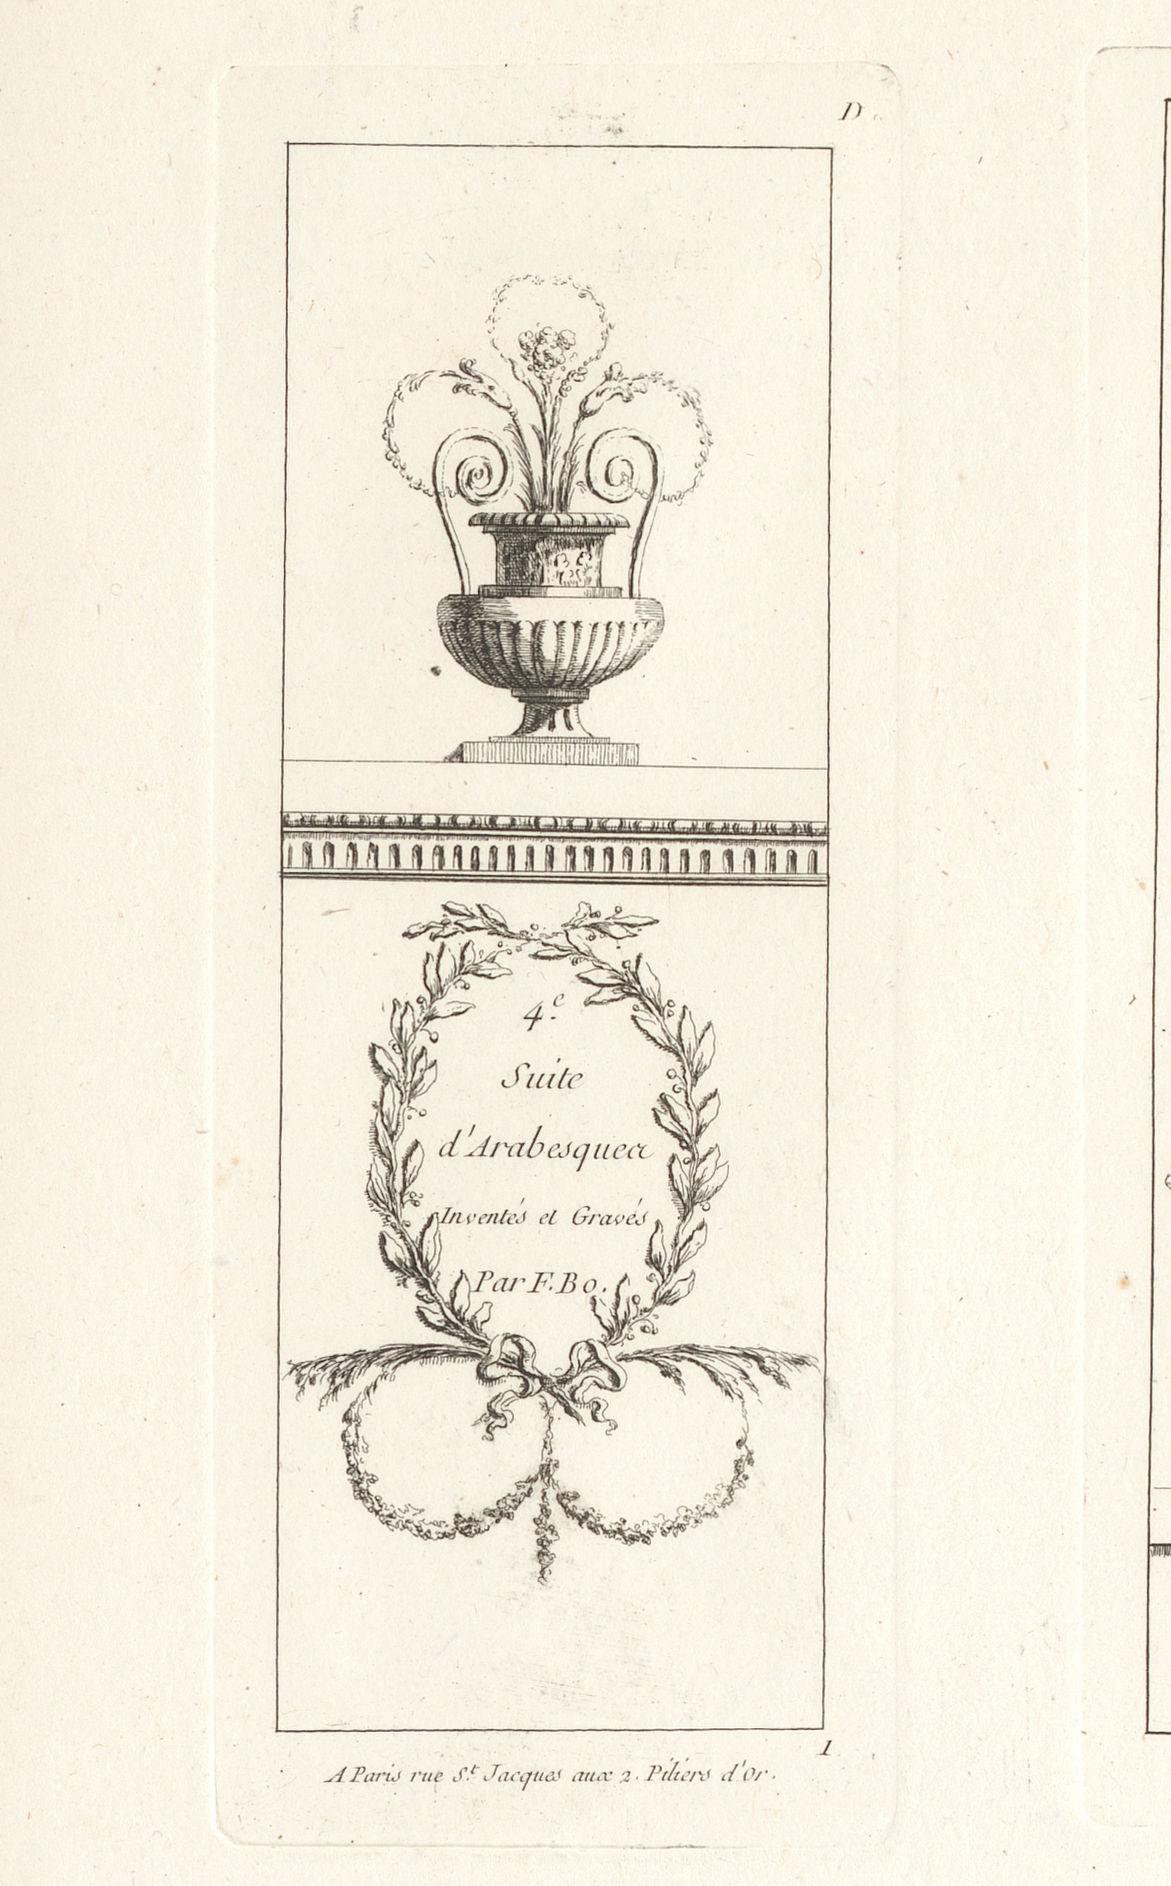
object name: ornament print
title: Verzameling van arabesken, met de Vaticaanse loggia's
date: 1802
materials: paper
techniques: etching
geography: paris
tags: ornament ~ arabesque, garland, wreath, vase ~ ornament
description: Doordat dit album bestaat uit meerdere, deels eerder uitgegeven prentreeksen, is de datering niet consequent. Het geheel is op de titelpagina gedateerd op 1802. Deze reeks is niet los gedateerd. De serietitel voor het gehele werk is "Recueil d'arabesques, contenant les loges du Vatican". De andere serietitel is de titel van de specifieke reeks binnen het geheel.